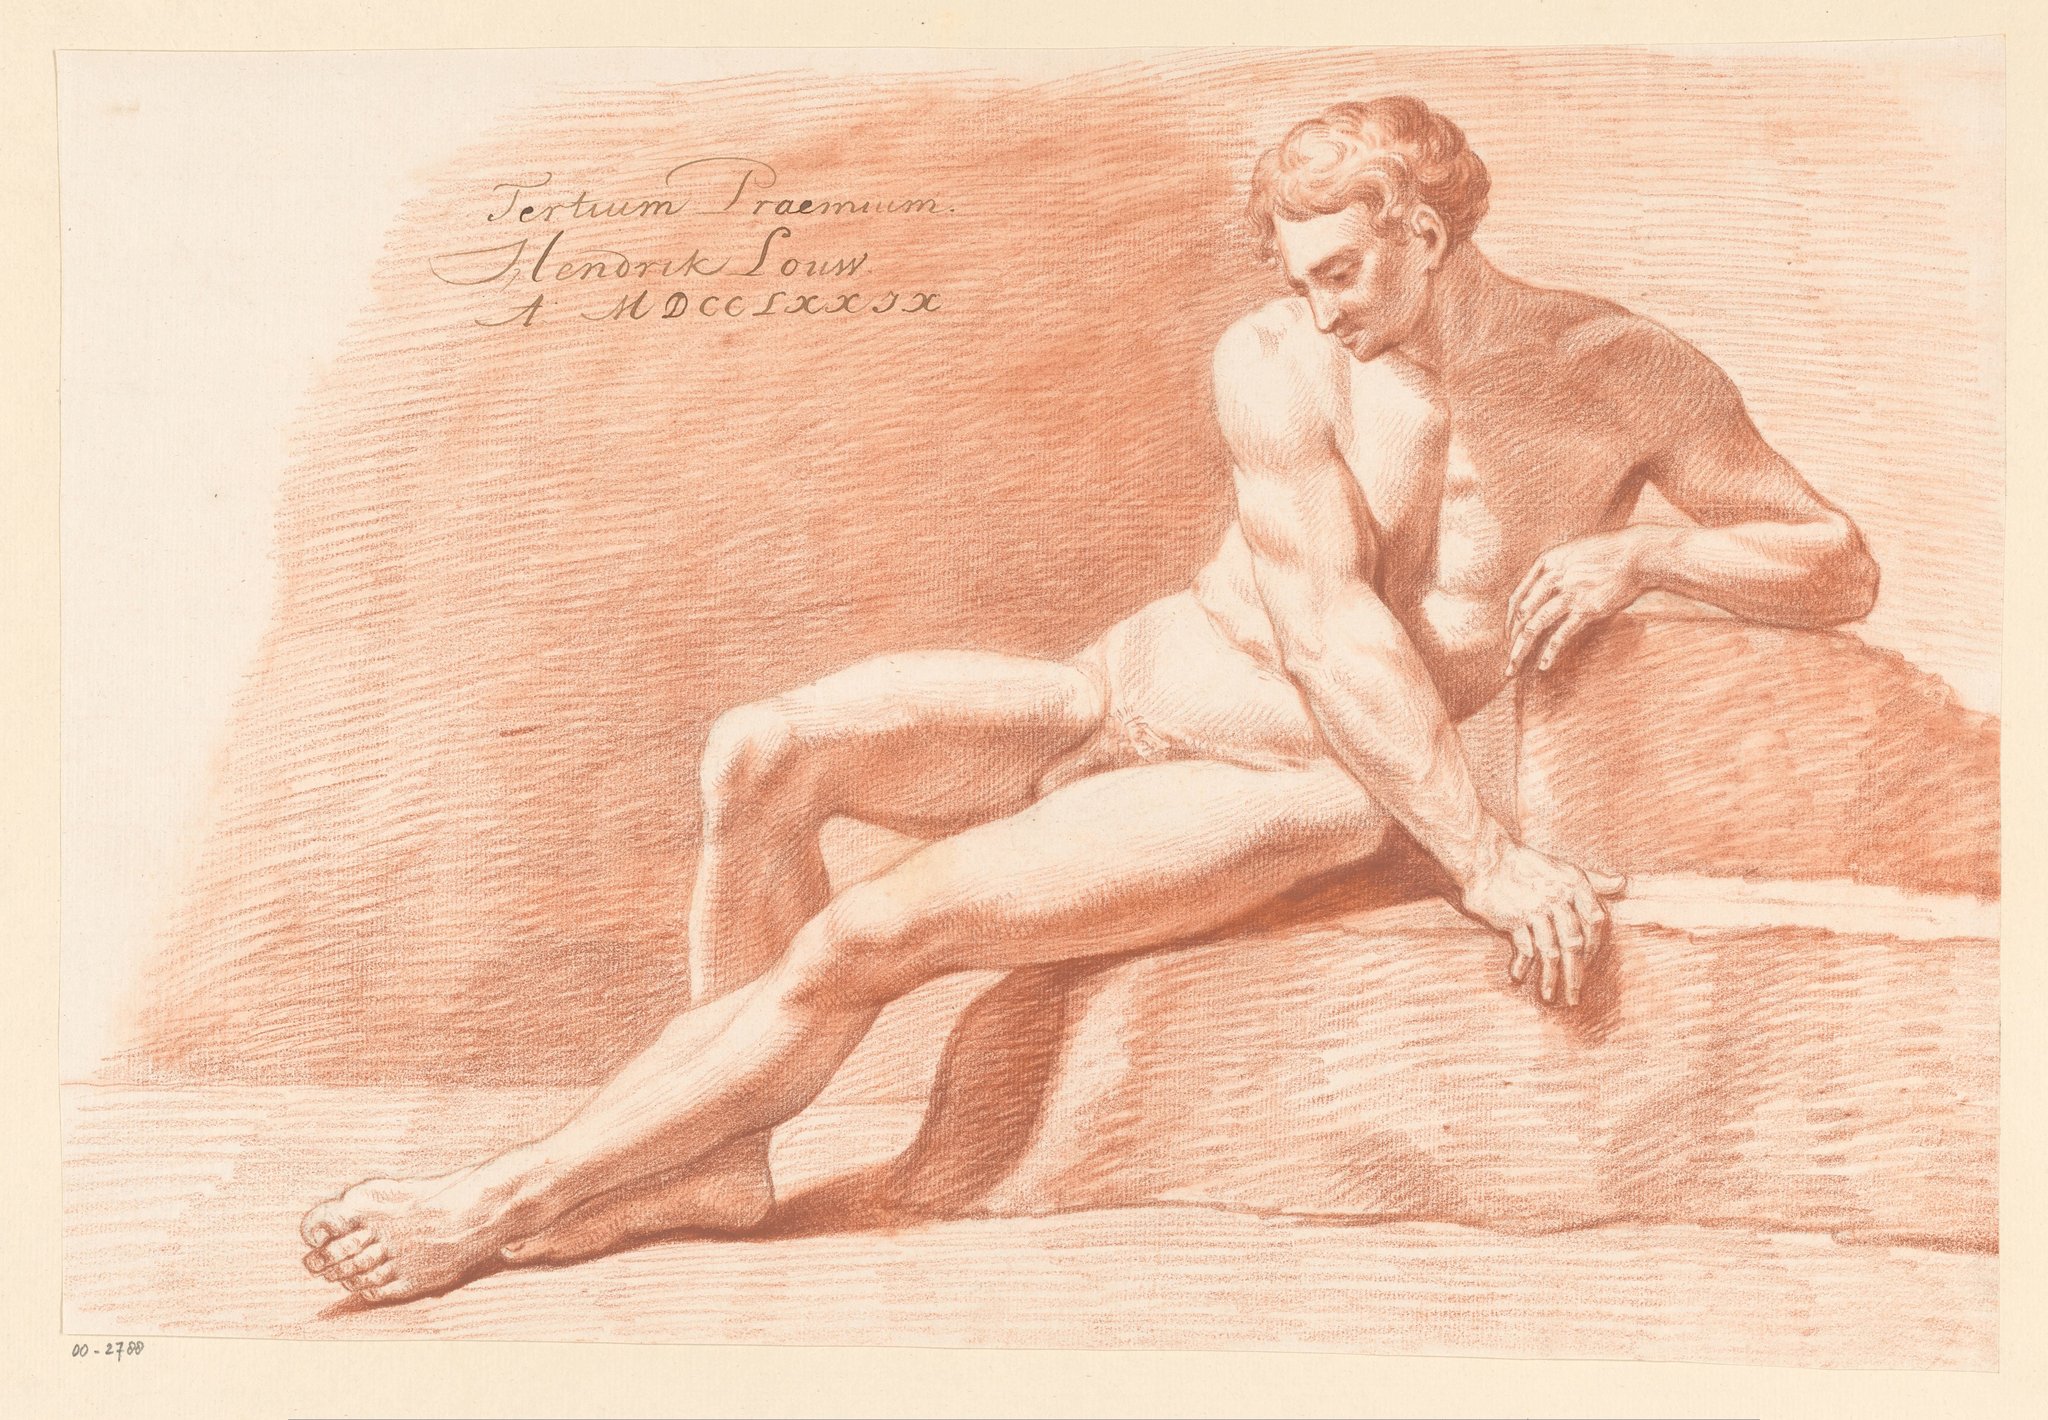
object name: drawing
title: Zittend mannelijk naakt, van voren gezien (3e prijs 1779)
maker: hendrik louw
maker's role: draughtsman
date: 1779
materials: chalk, charcoal, paper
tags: sitting figure (+ nude human being)